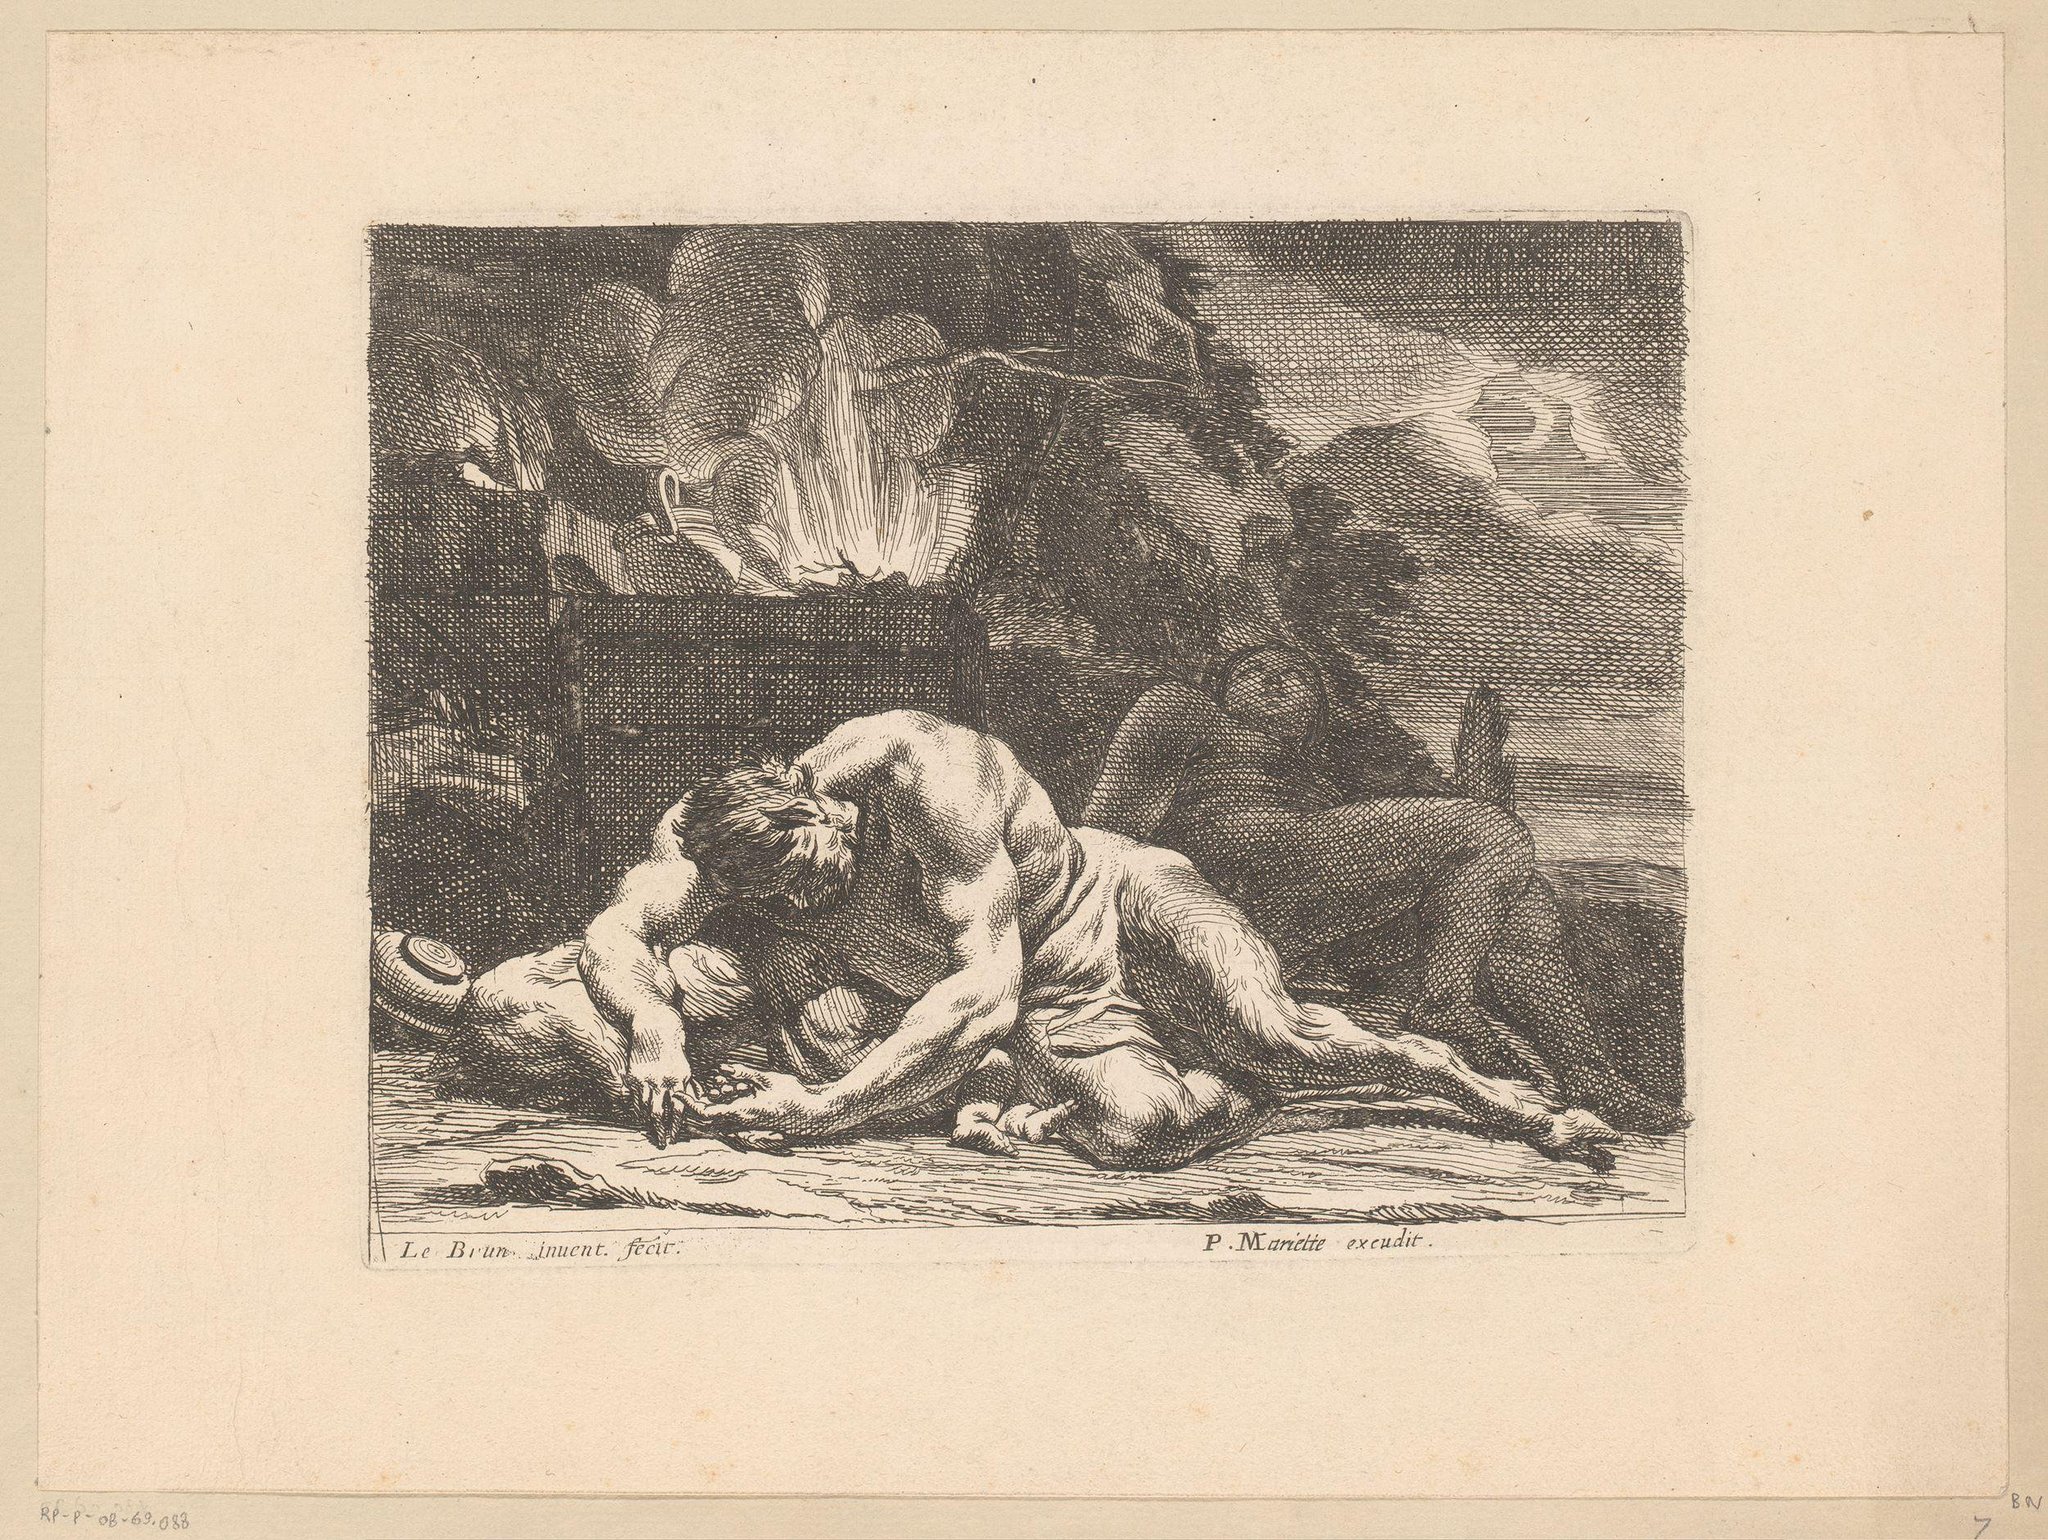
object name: print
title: Personificatie van verschillende tijdstippen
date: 1640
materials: paper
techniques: engraving, etching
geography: paris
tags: personification of the night, 'nox'; 'notte', 'carro della notte', 'serenità della notte' (ripa), maenad(s), female bacchant(es), satyr(s) (in general)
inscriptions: collector's mark: Lugt 240